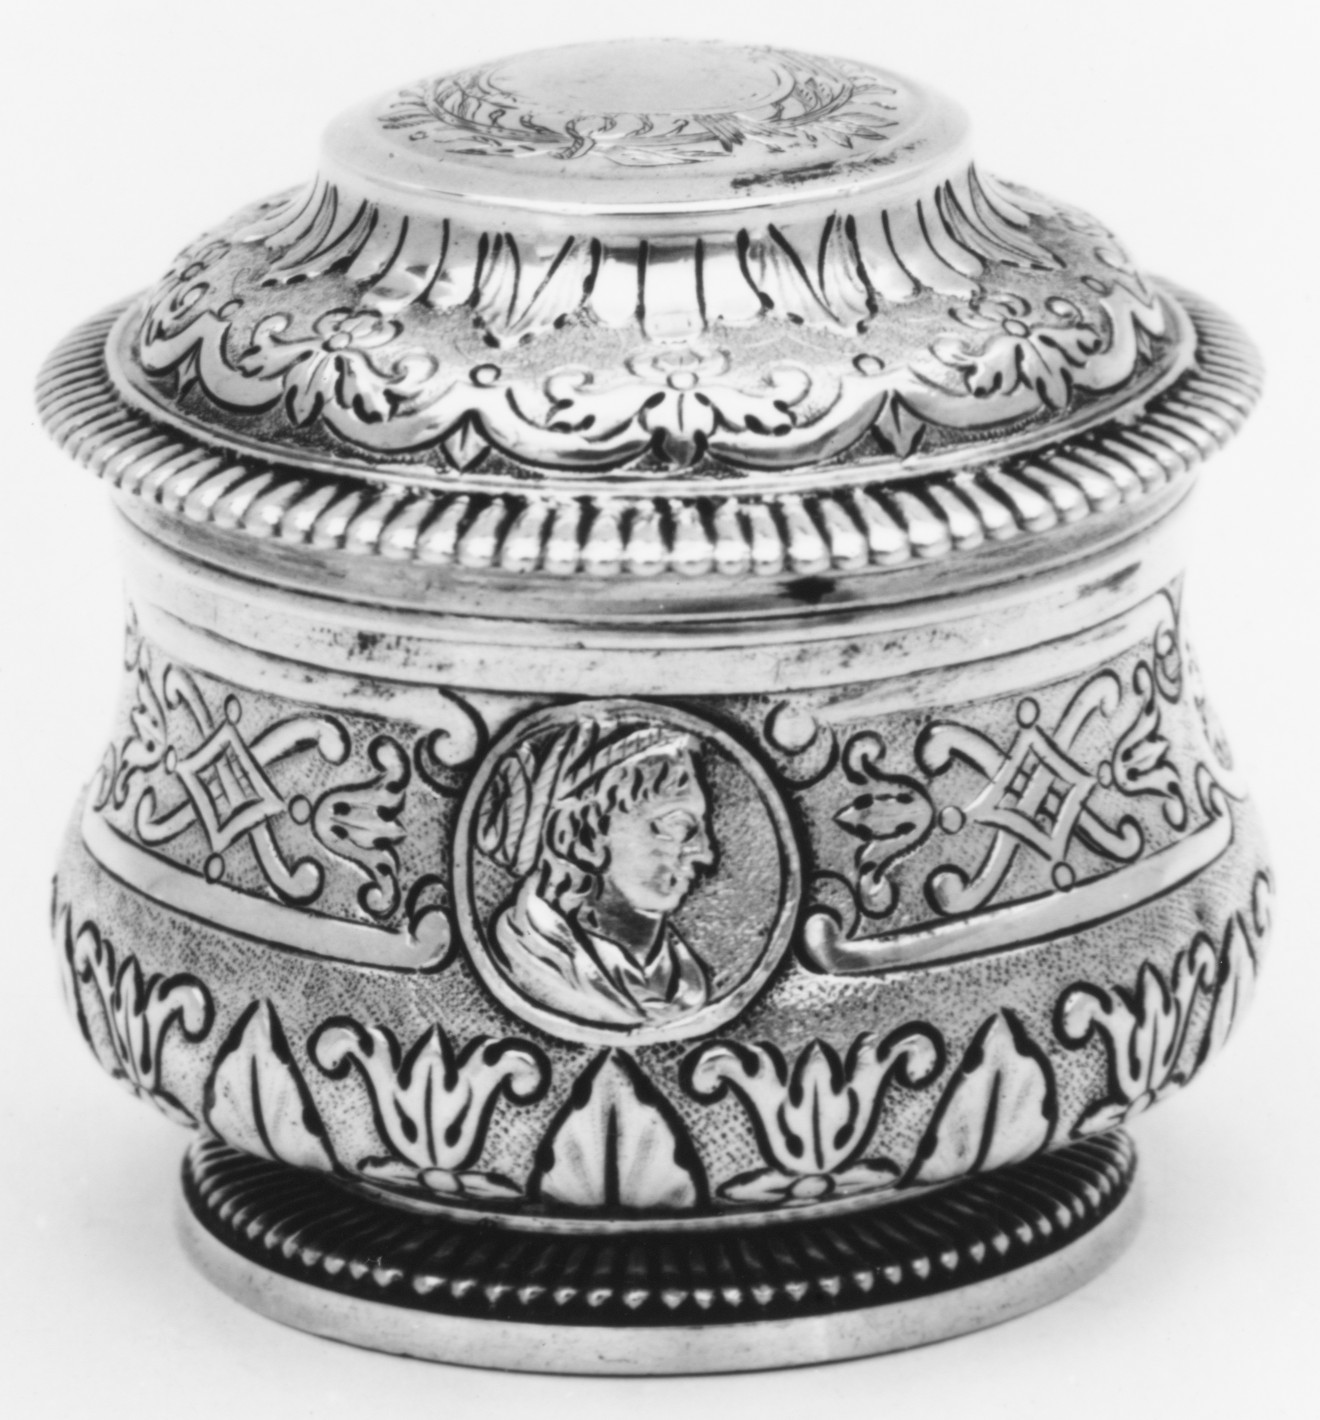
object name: box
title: Box (one of a pair) (part of a toilet service)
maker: jean-baptiste boullemer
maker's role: maker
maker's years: 1682-1739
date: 1726-1728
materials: silver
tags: profiles